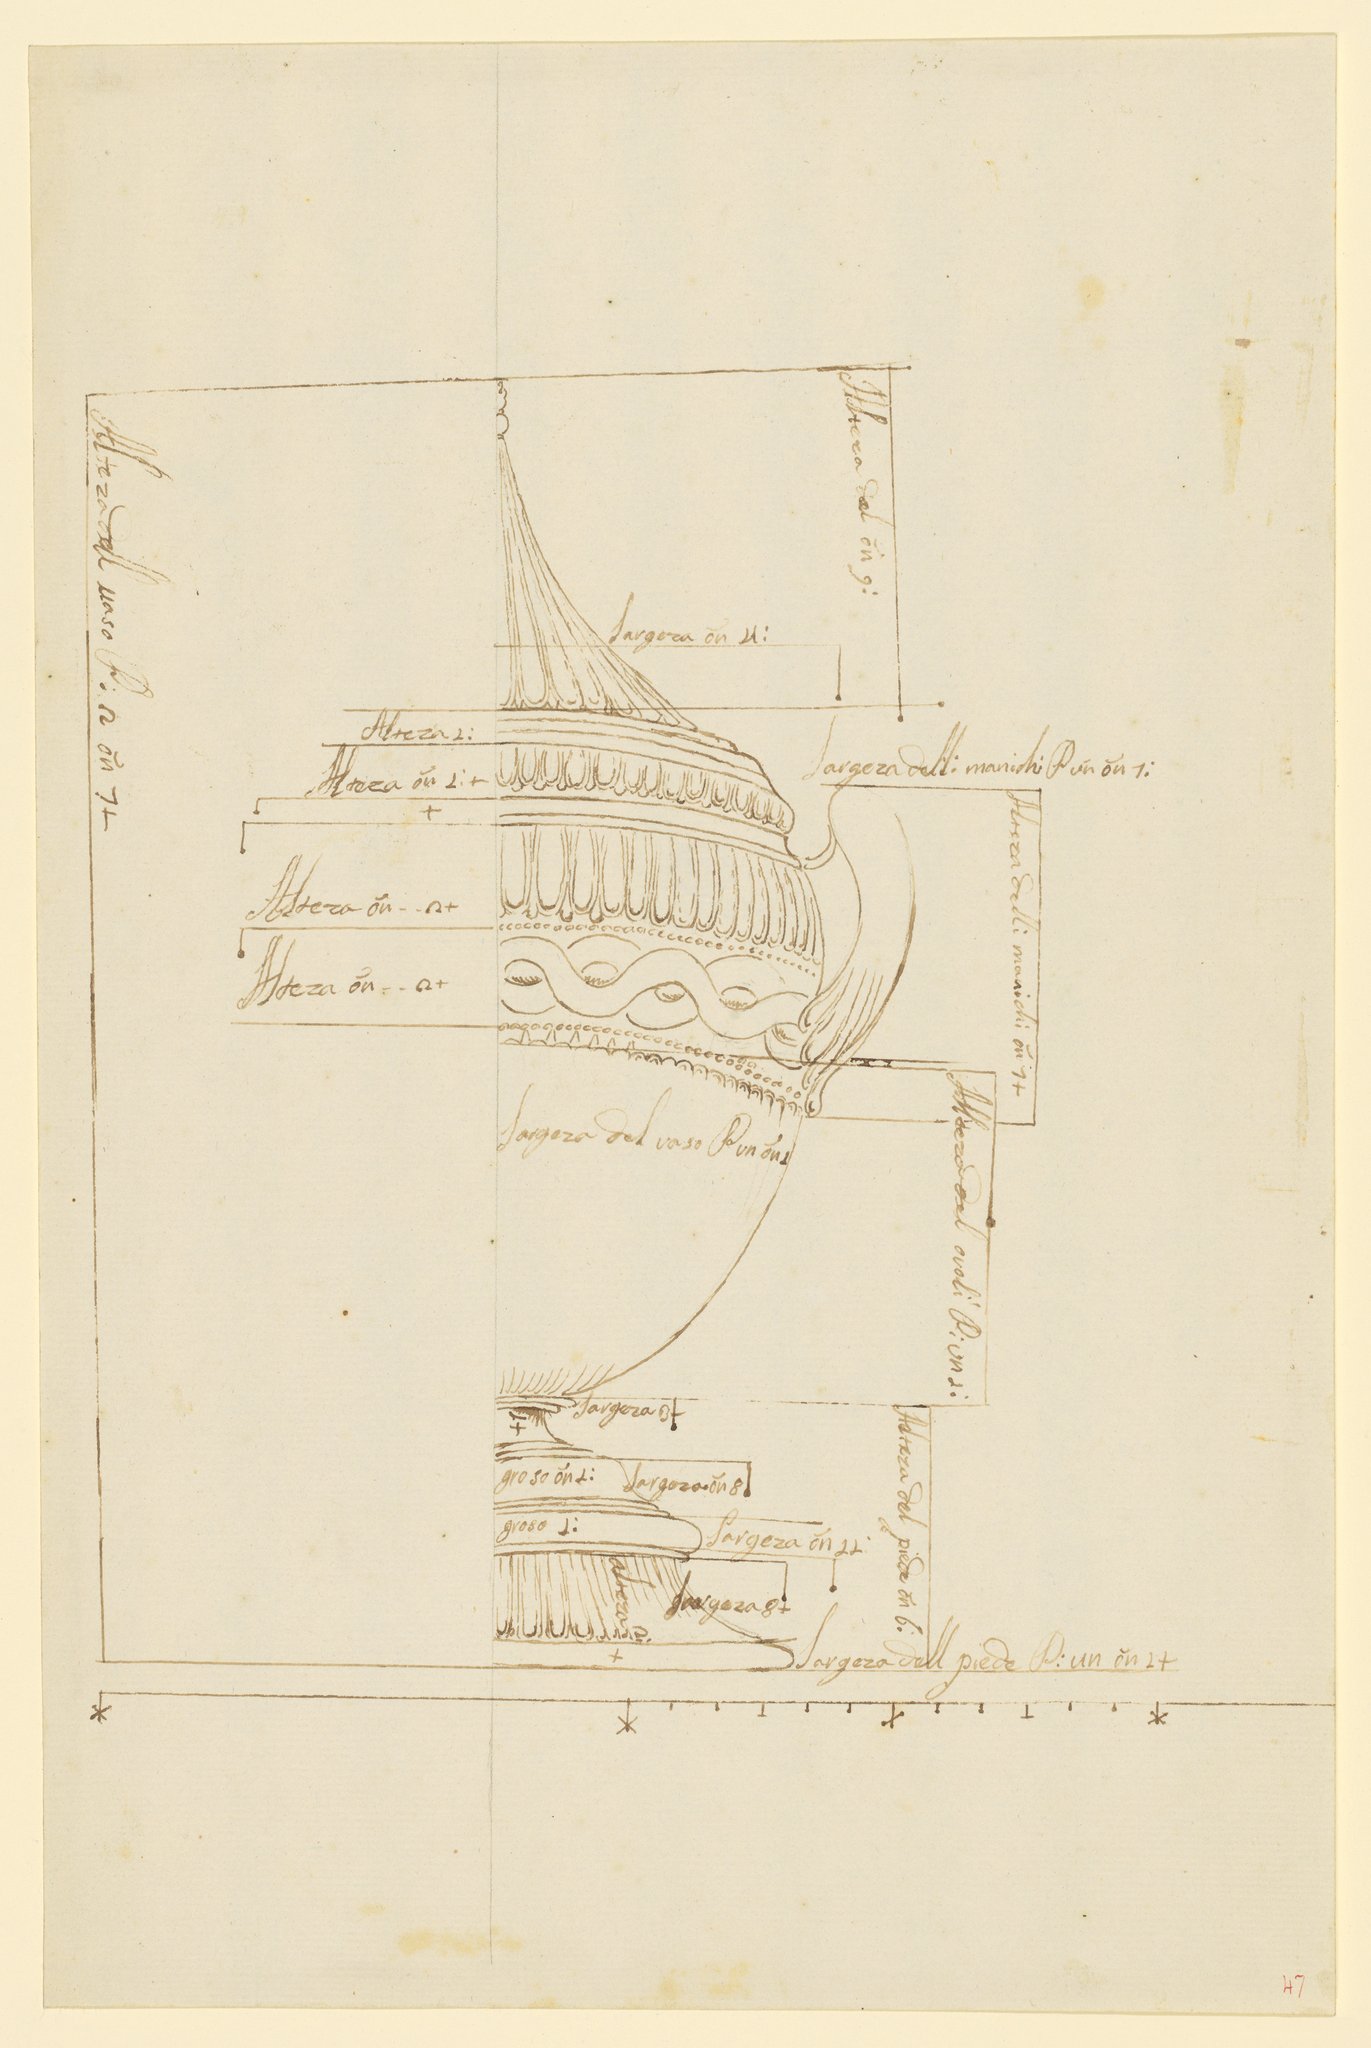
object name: drawing ornament architecture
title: Design for an Urn with a Pointed Lid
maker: anonymous, french, 18th century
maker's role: artist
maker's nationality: french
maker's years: 1700-1800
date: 1770-1790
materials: ink, drawing material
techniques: pen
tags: urns